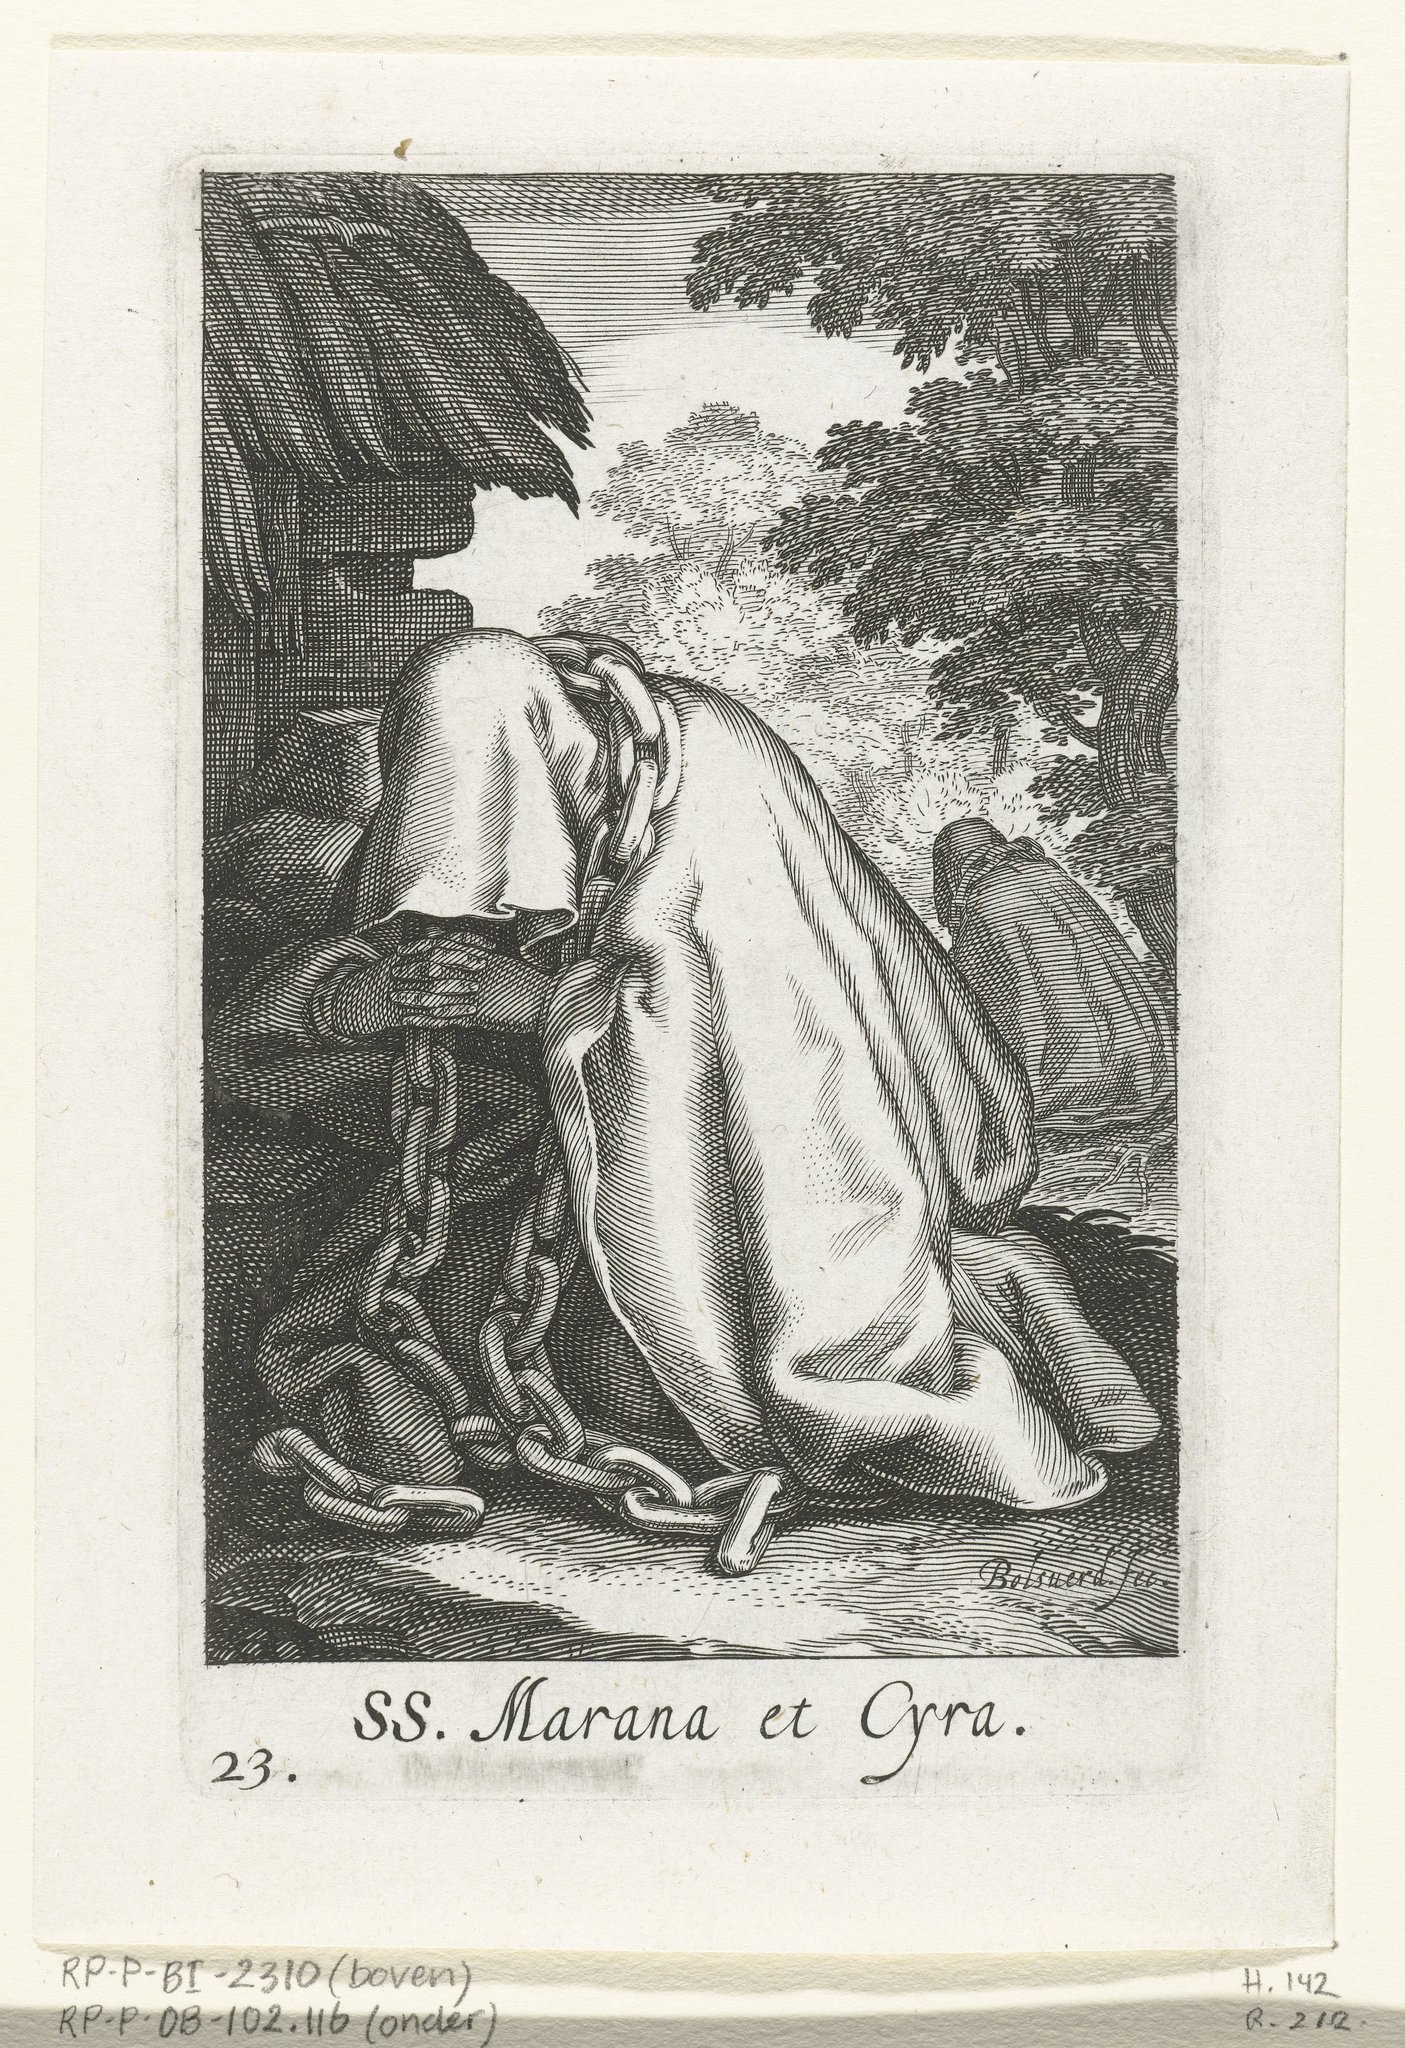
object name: book illustration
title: Kluizenaressen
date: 1590-1612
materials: paper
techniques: engraving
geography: antwerp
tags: anchorite, hermit, female saints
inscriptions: collector's mark: Lugt 2228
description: Prent uit: Sacra Eremus Ascetriarum, uitgever Boëtius Adamsz. Bolswert, 1612 of Hendrik Aertssen, Antwerpen 1619. Prent uit de serie van vijfentwintig kluizenaressen in deze uitgaven. In 1612 verscheen een ongebonden editie maar op basis van de gewijzigde opschriften en samenstelling van de serie kluizenaars wordt aangenomen dat de prenten van de uitgave 1619 ook in 1612 of iets daarvoor gedrukt werden. De serie kluizenaressen bleef vrijwel ongewijzigd in de ongebonden uitgave van 1612, dit compliceert de datering van de losse bladen in de collectie van het RMA, zie Roethlisberger 1993, p. 171-175.